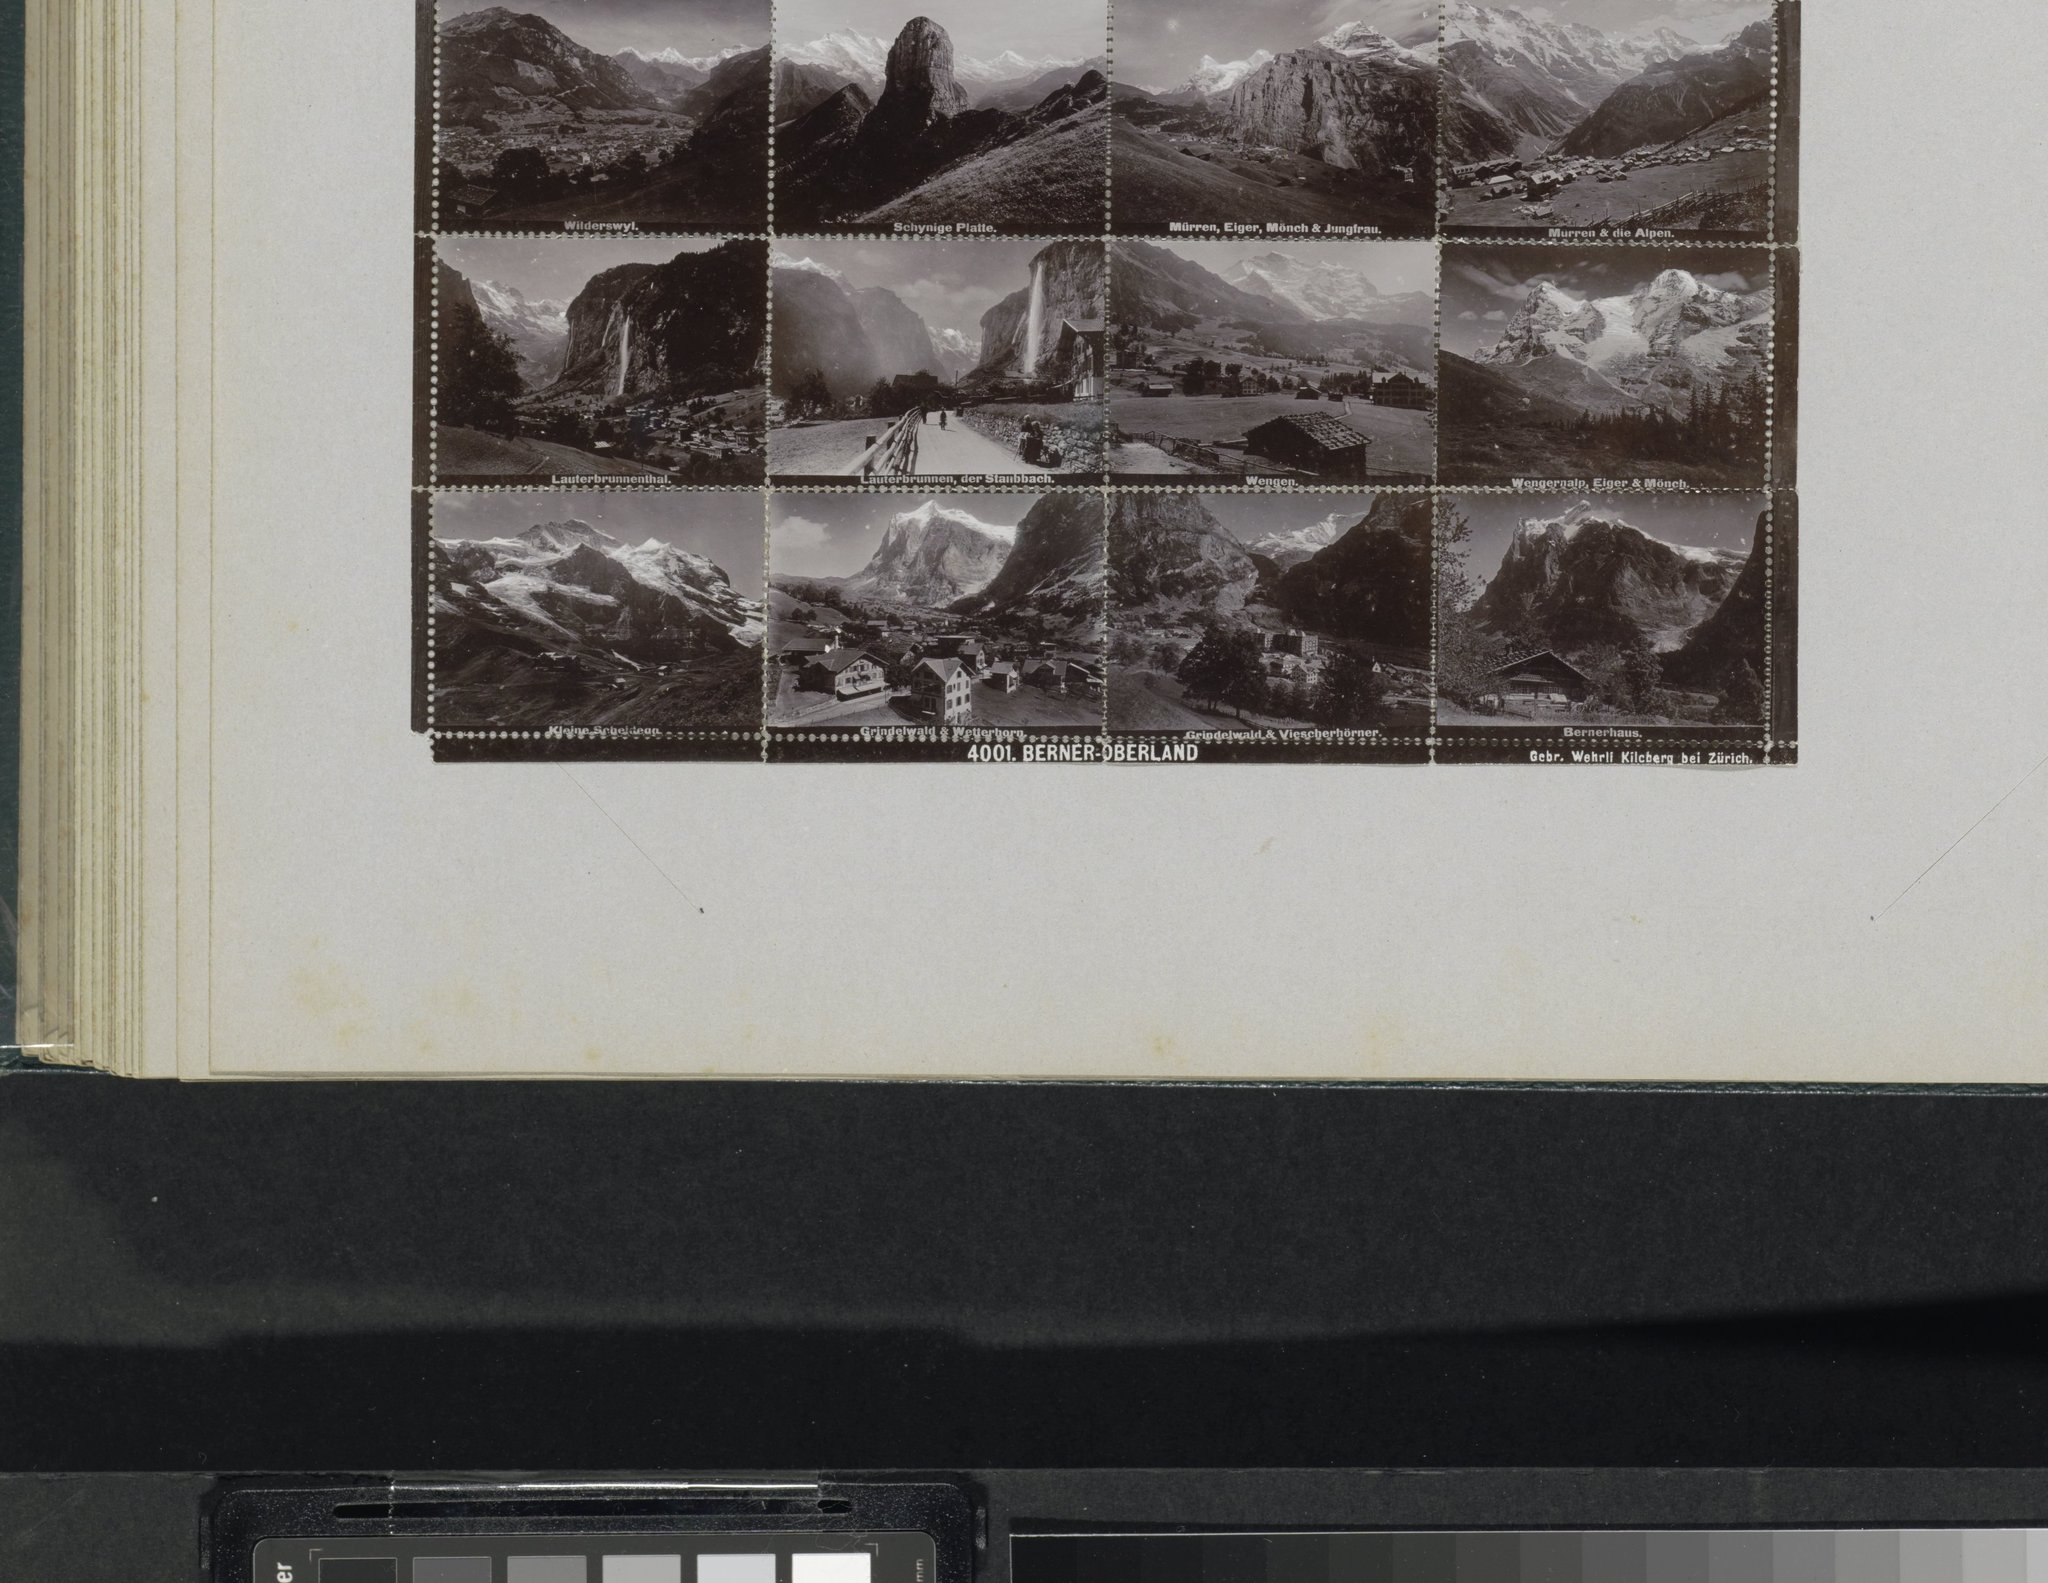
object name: postage stamp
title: Zestien sluitzegels met bezienwaardigheden te Berner-Oberland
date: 1896-1897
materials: photographic support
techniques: collodion silver print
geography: berner oberland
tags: mountain-range, snow peaks, city-view in general; 'veduta' (+ city(-scape) with figures, staffage)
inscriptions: inscription: ‘4001. Berner-Oberland/ Gebr. Wehrli Kilcberg bei Zürich’